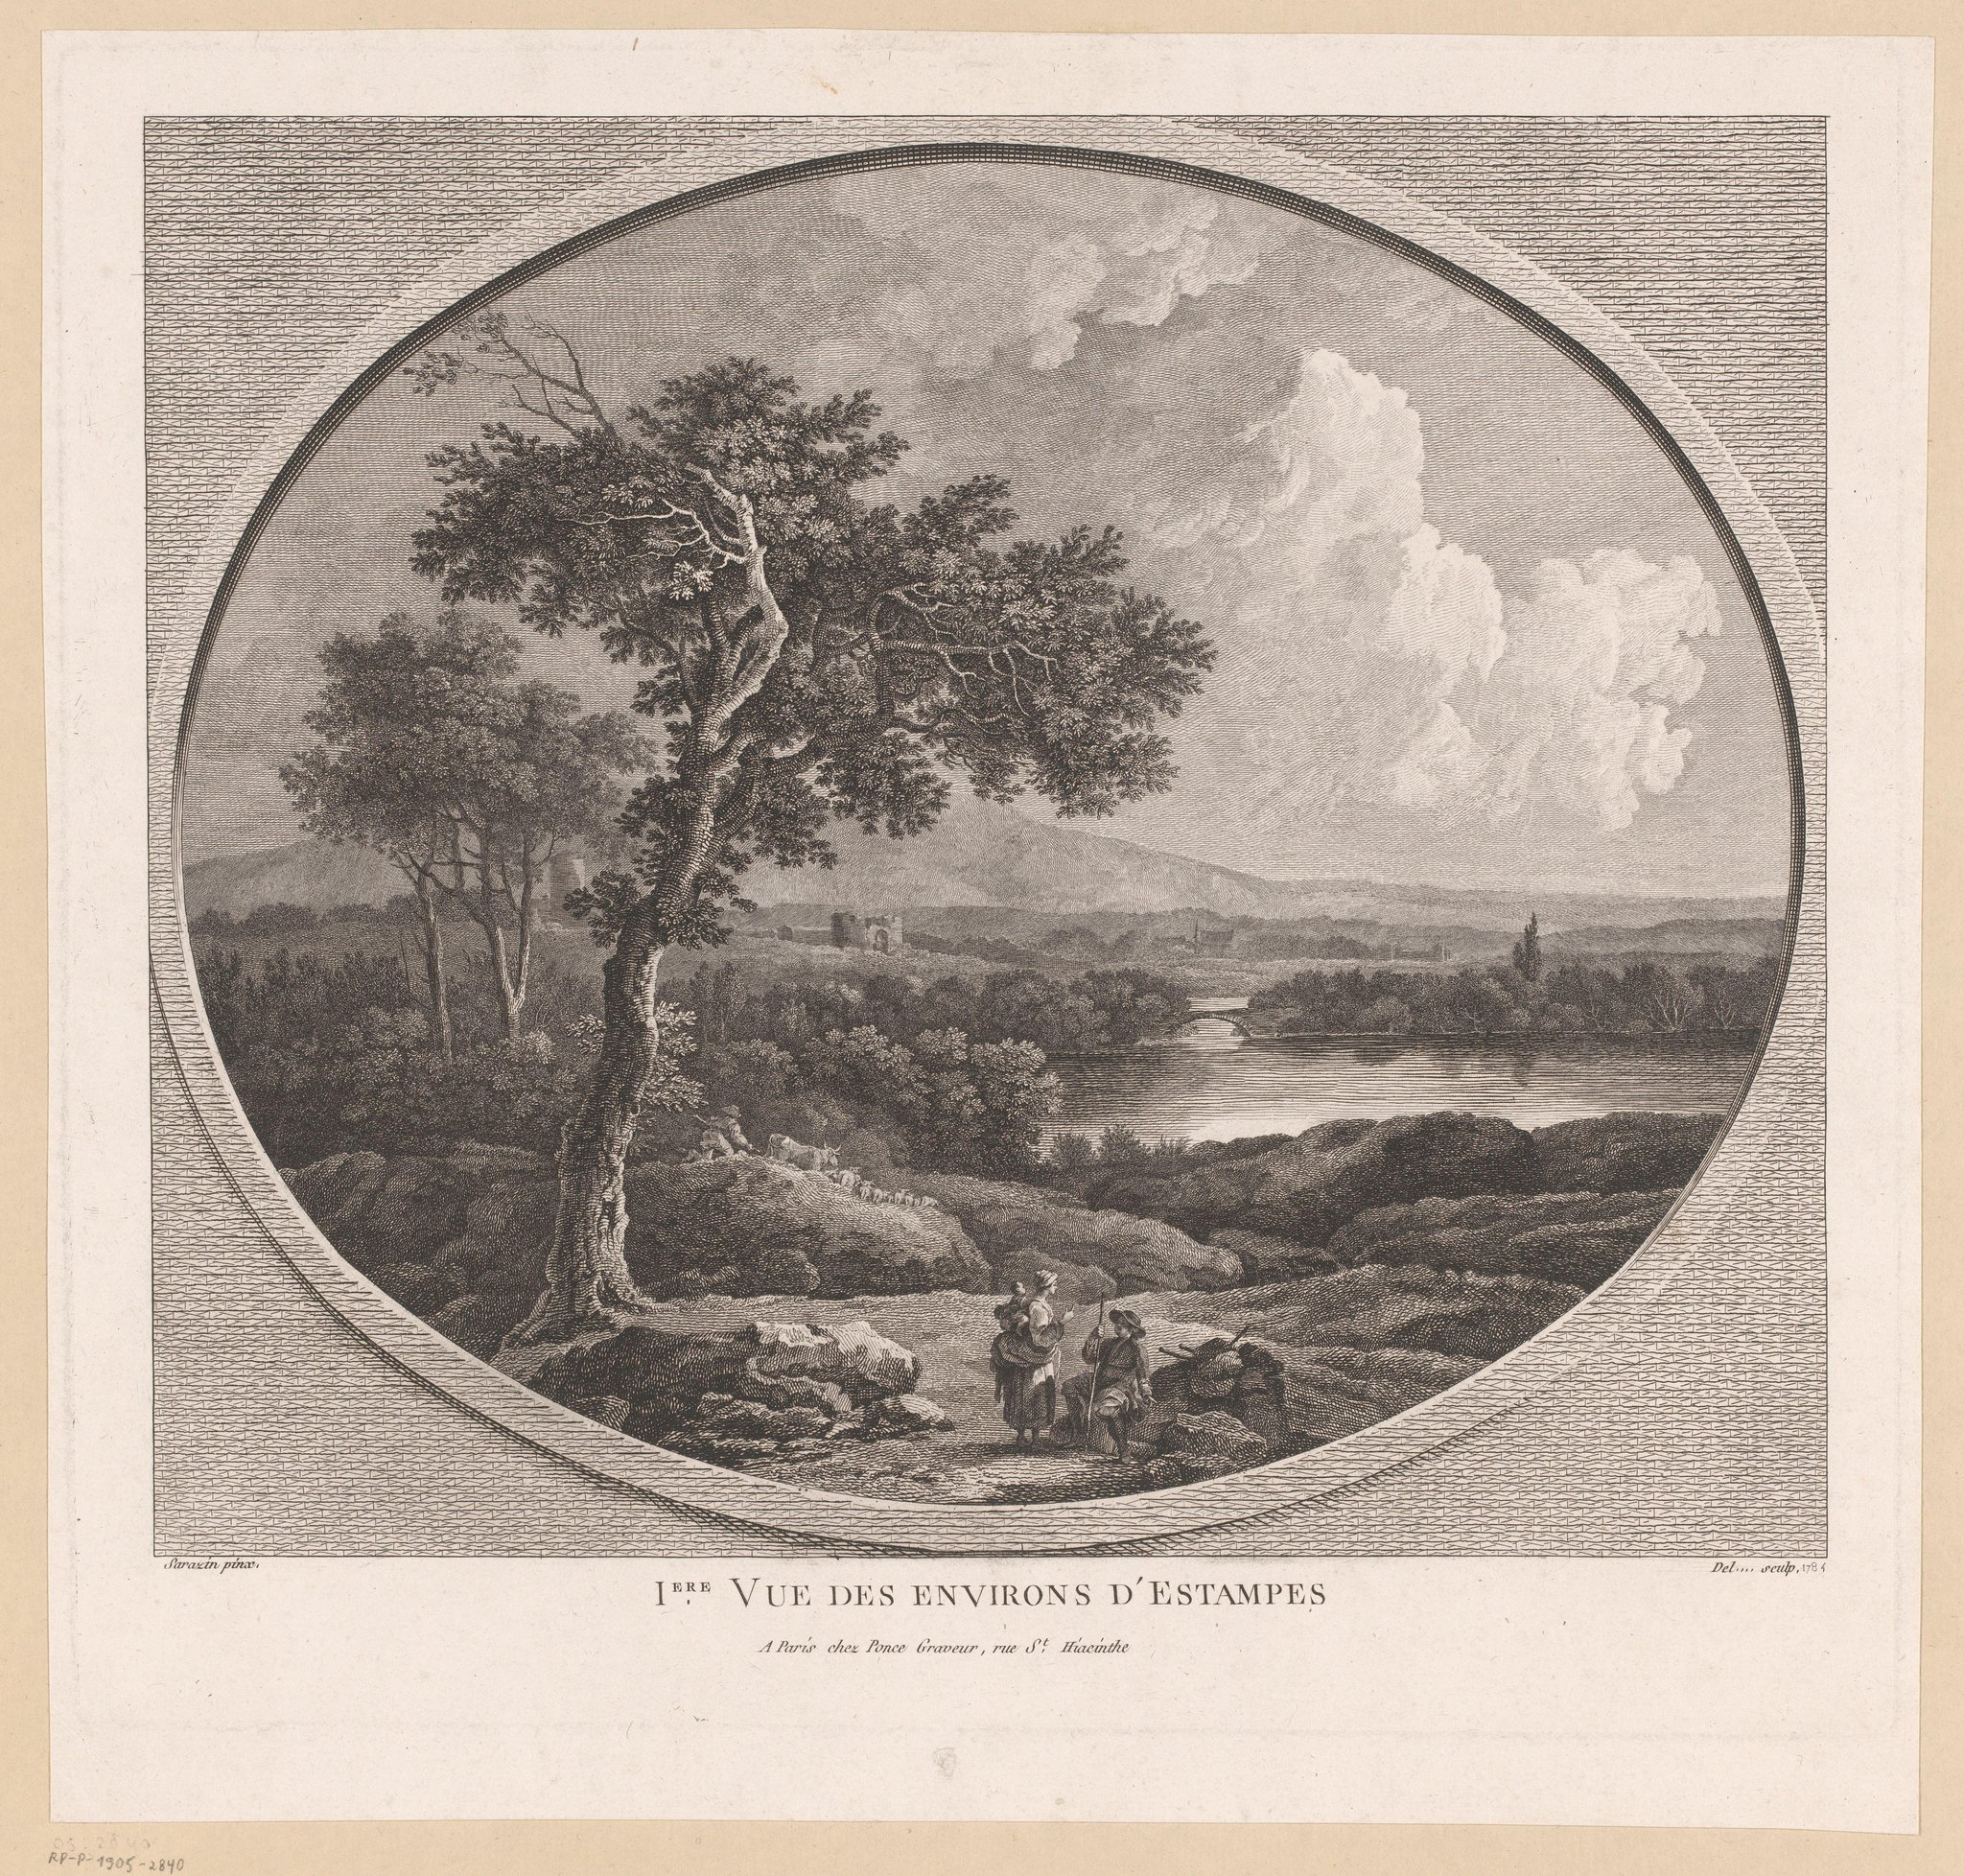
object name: print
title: Landschap met rivier en rustend gezin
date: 1784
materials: paper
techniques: etching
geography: paris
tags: landscapes with waters, waterscapes, seascapes (in the temperate zone), family, relationship, descent, resting - bb - out of doors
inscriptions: collector's mark: Lugt 2228